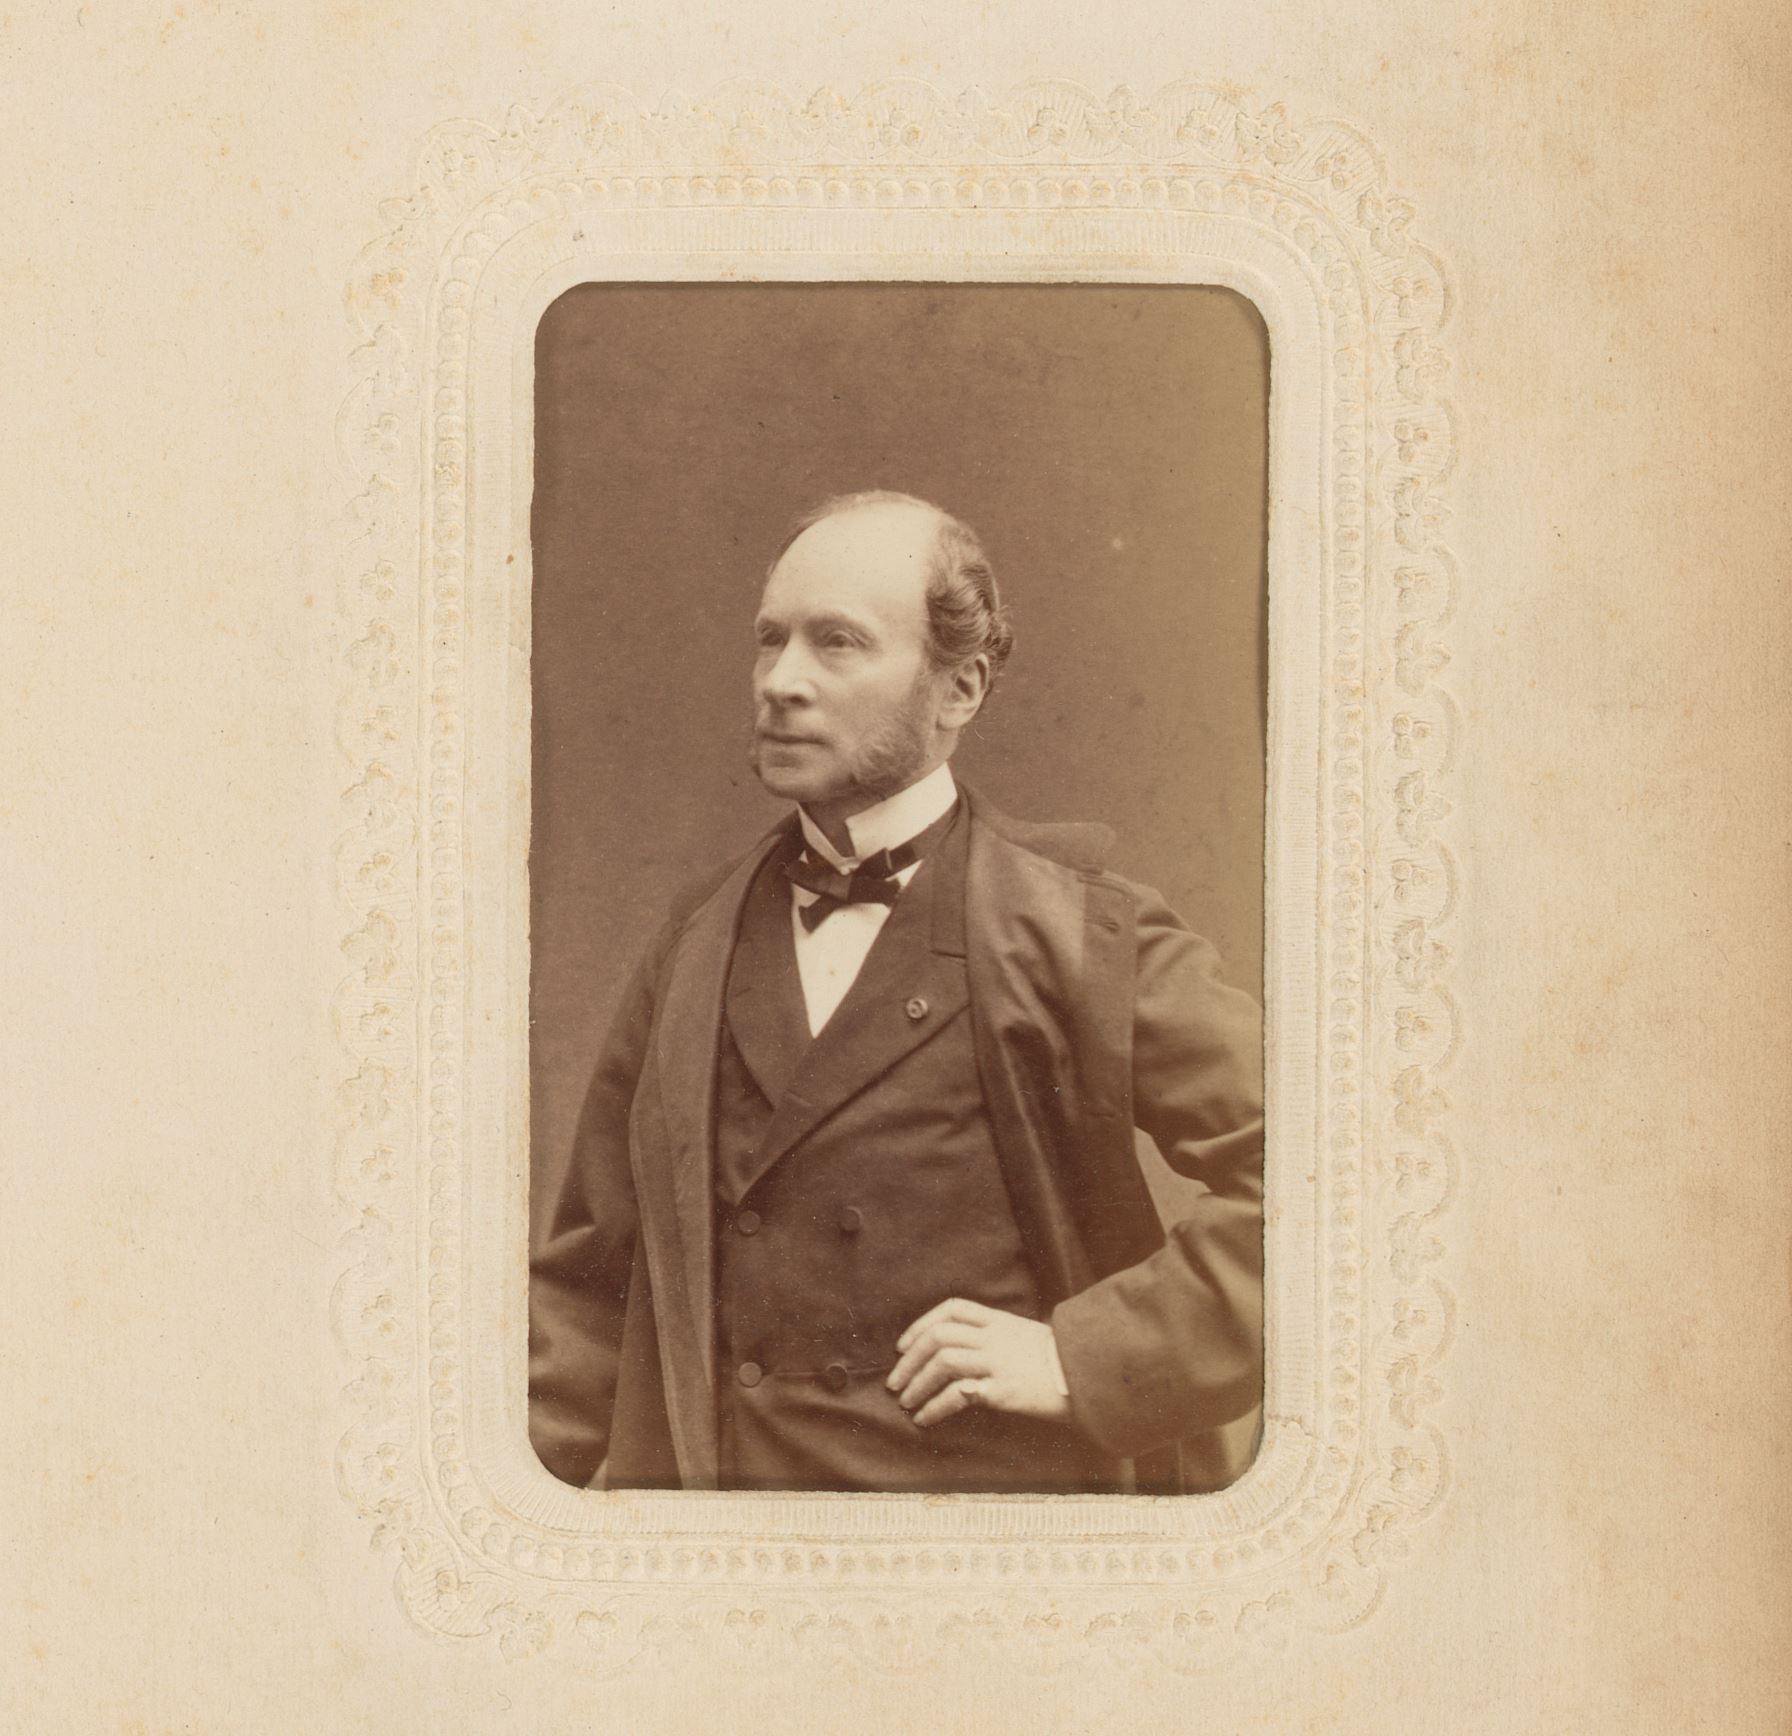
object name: photograph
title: Portret van een man met bakkebaarden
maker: Anonymous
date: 1860-1890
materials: cardboard, photographic support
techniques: albumen print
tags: sideburns, historical persons